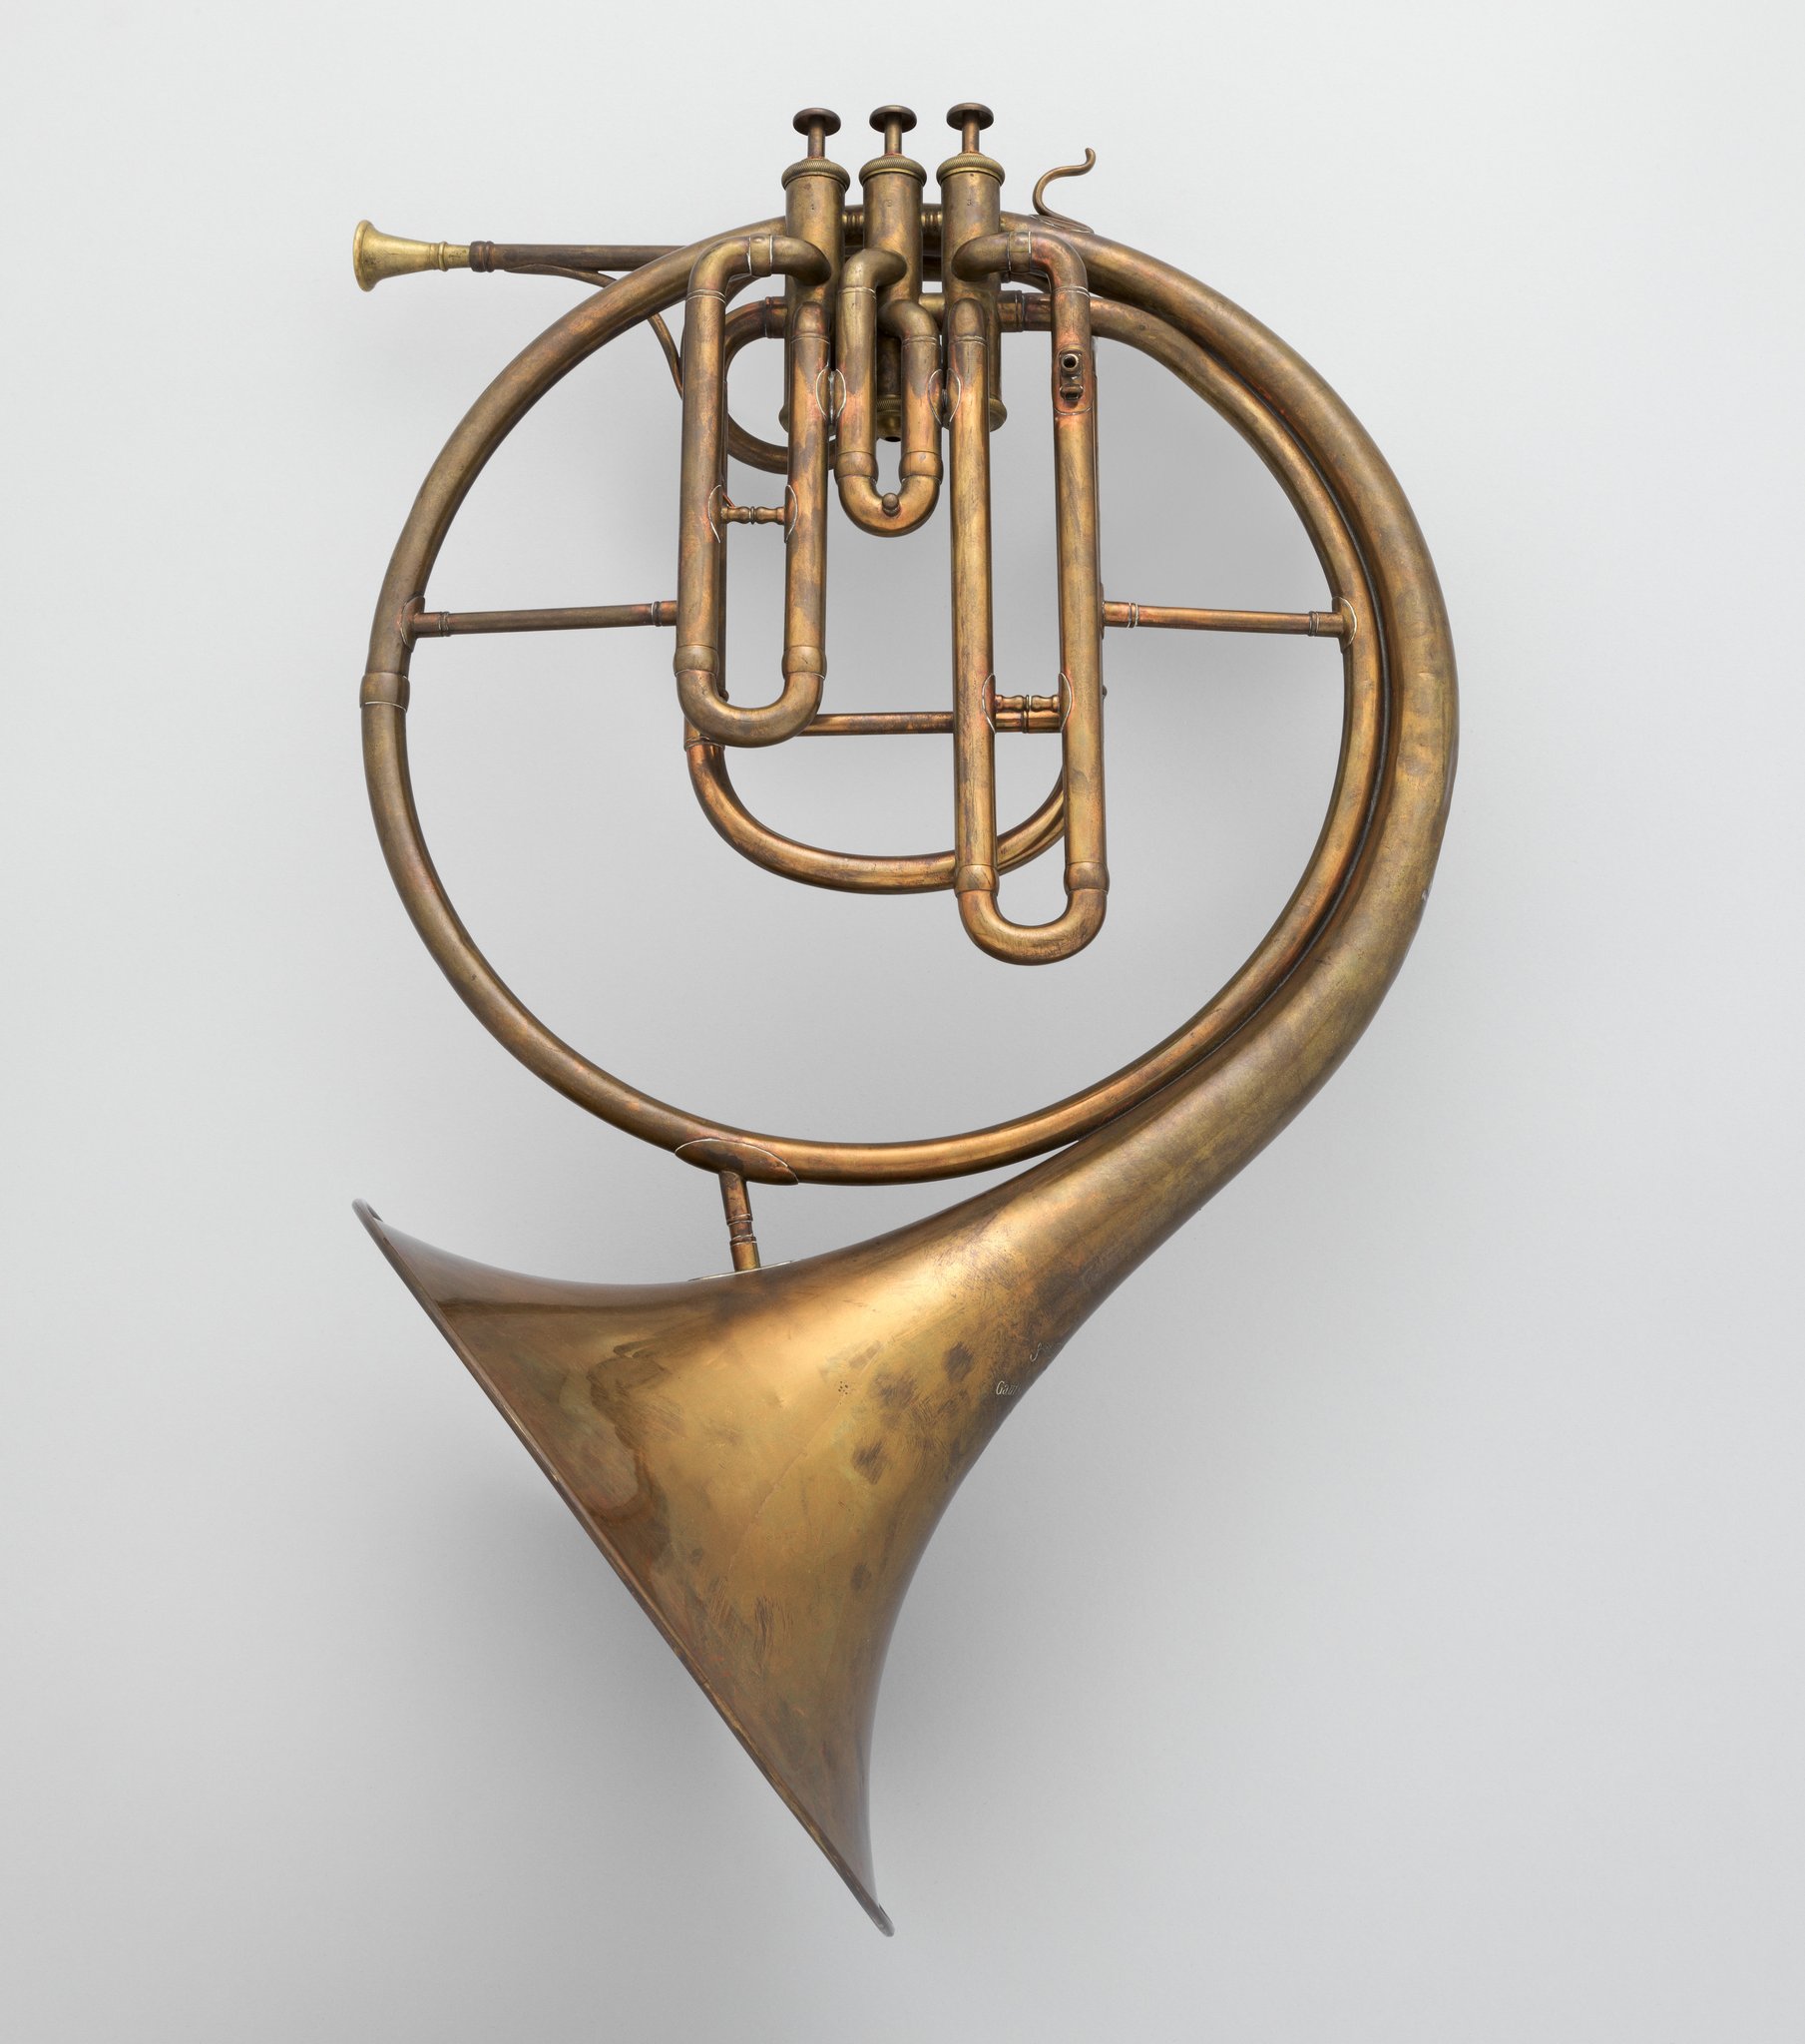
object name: french horn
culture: french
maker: gautrot brevete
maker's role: maker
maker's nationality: french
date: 1890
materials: brass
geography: france